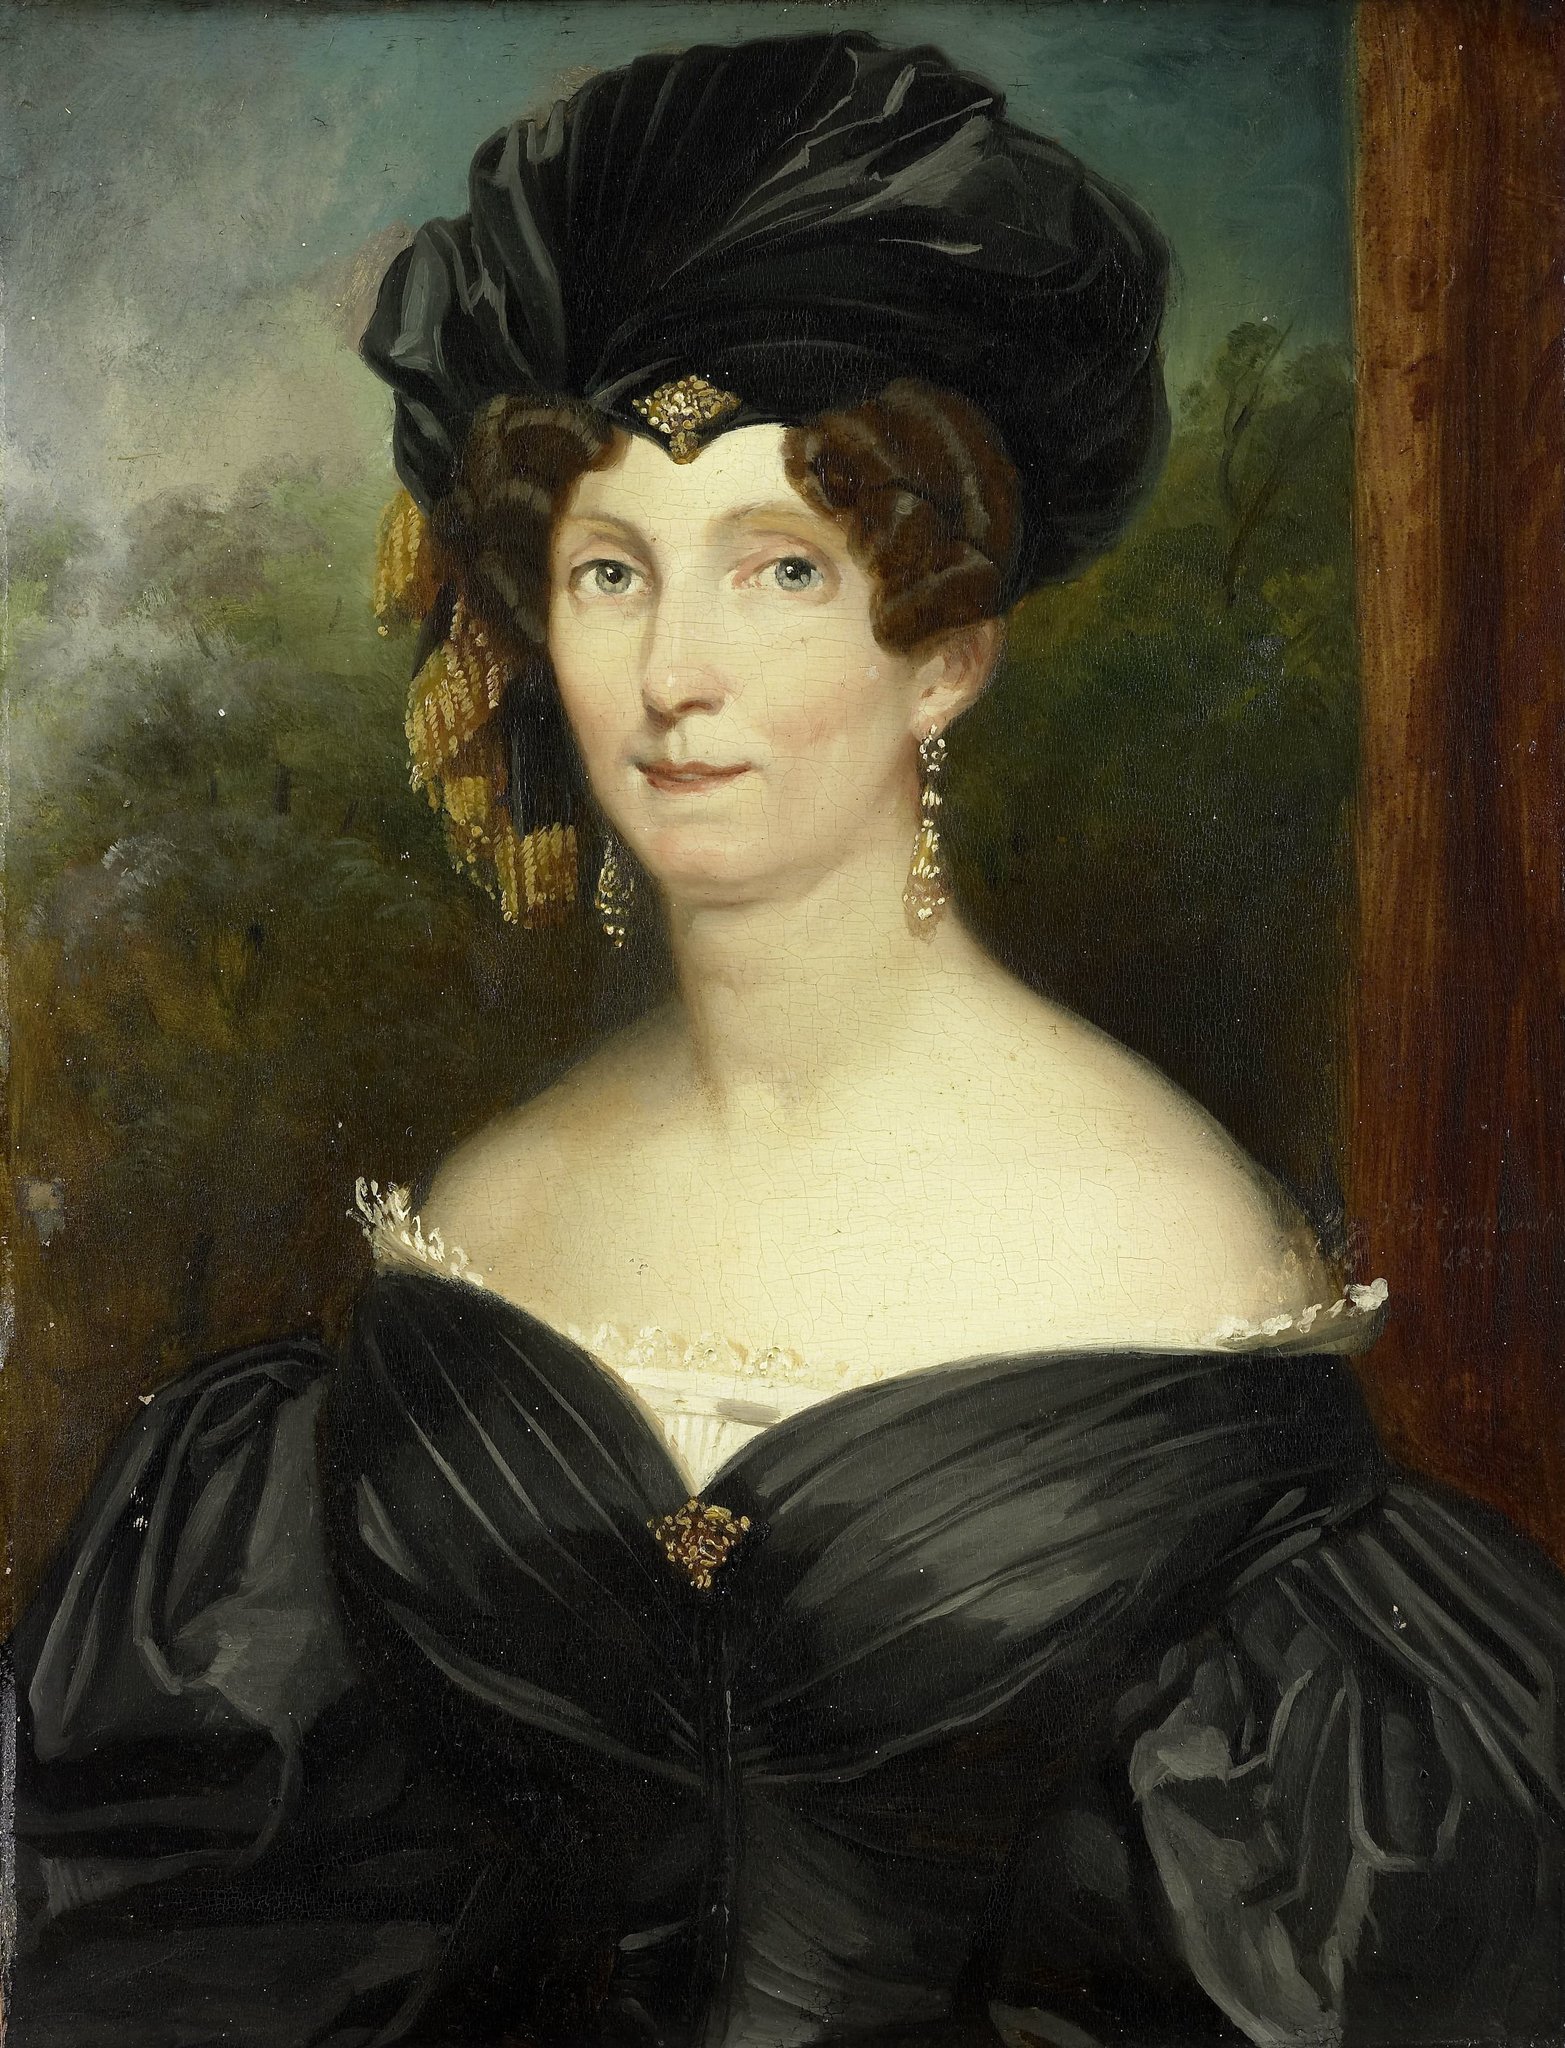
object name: painting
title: Petronella de Lange (1779-1835), Wife of Jonkheer Theodorus Frederik van Capellen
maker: jacob joseph eeckhout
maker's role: draughtsman, print maker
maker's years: 1793-1861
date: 1835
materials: oil, panel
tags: nijmegen, brussels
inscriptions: signature and date: ‘J.J. Eeckhout 1835’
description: Portret van Petronella de Lange, echtgenote van Jonkheer Theodorus Frederik van Capellen. Buste in een zwarte zijden japon. Op het hoofd een tulbandachtig hoofddeksel. Pendant van SK-A-4058.